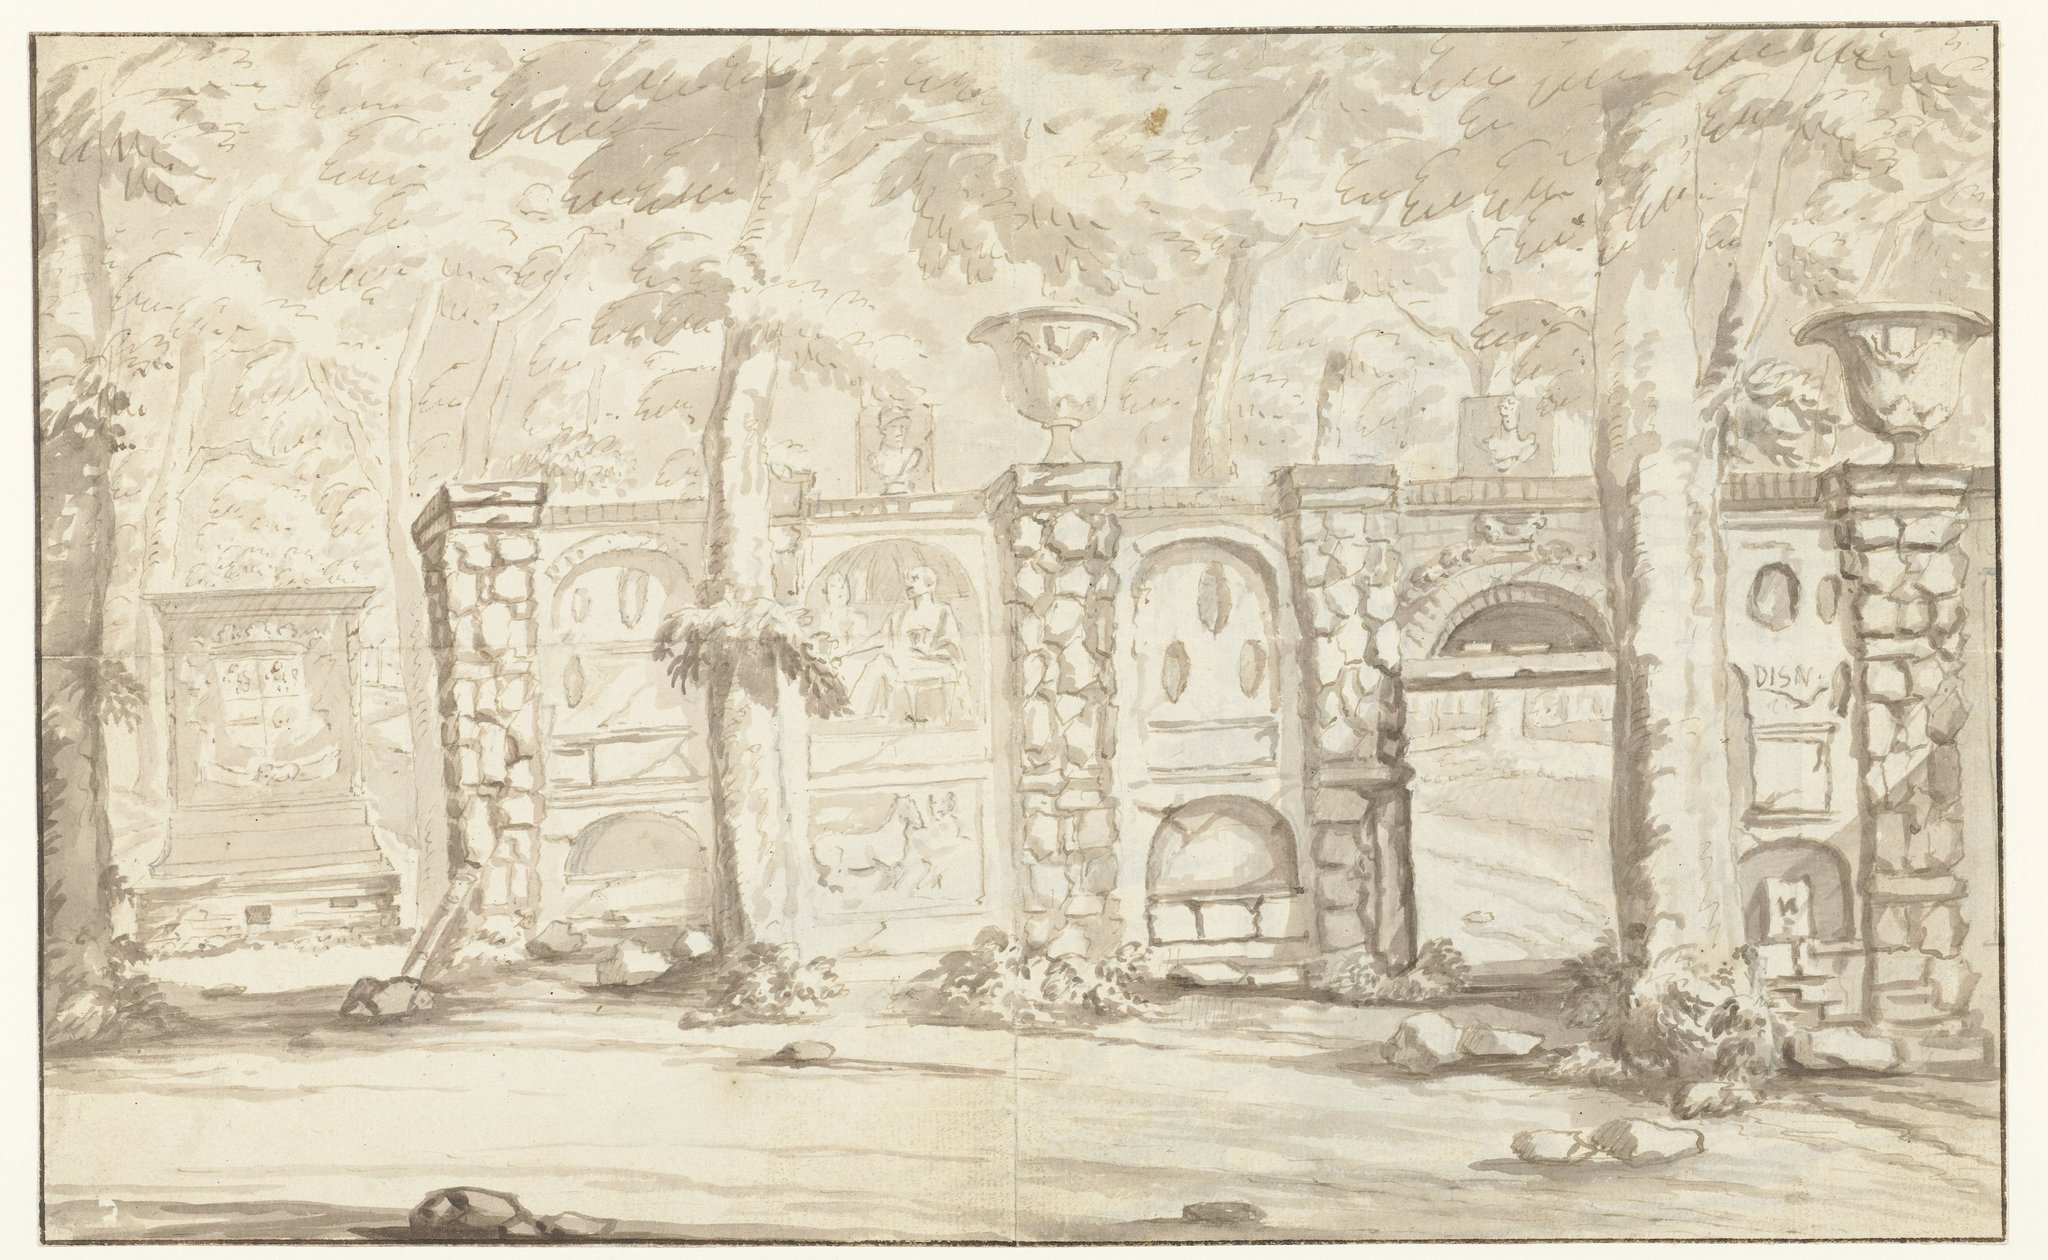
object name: drawing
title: Graftombe van Johan Maurits van Nassau-Siegen en deel van amfitheater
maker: arnoud van halen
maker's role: draughtsman, painter, print maker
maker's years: 1673-1732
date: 1710-1730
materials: ink, paper, pencil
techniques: brush, pen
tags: grave, tomb, theatre (building) - aa - open-air performances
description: De graftombe van Johan Maurits van Nassau-Siegen en een deel van de exedra van het amfitheater te Bergendael bij Kleef.